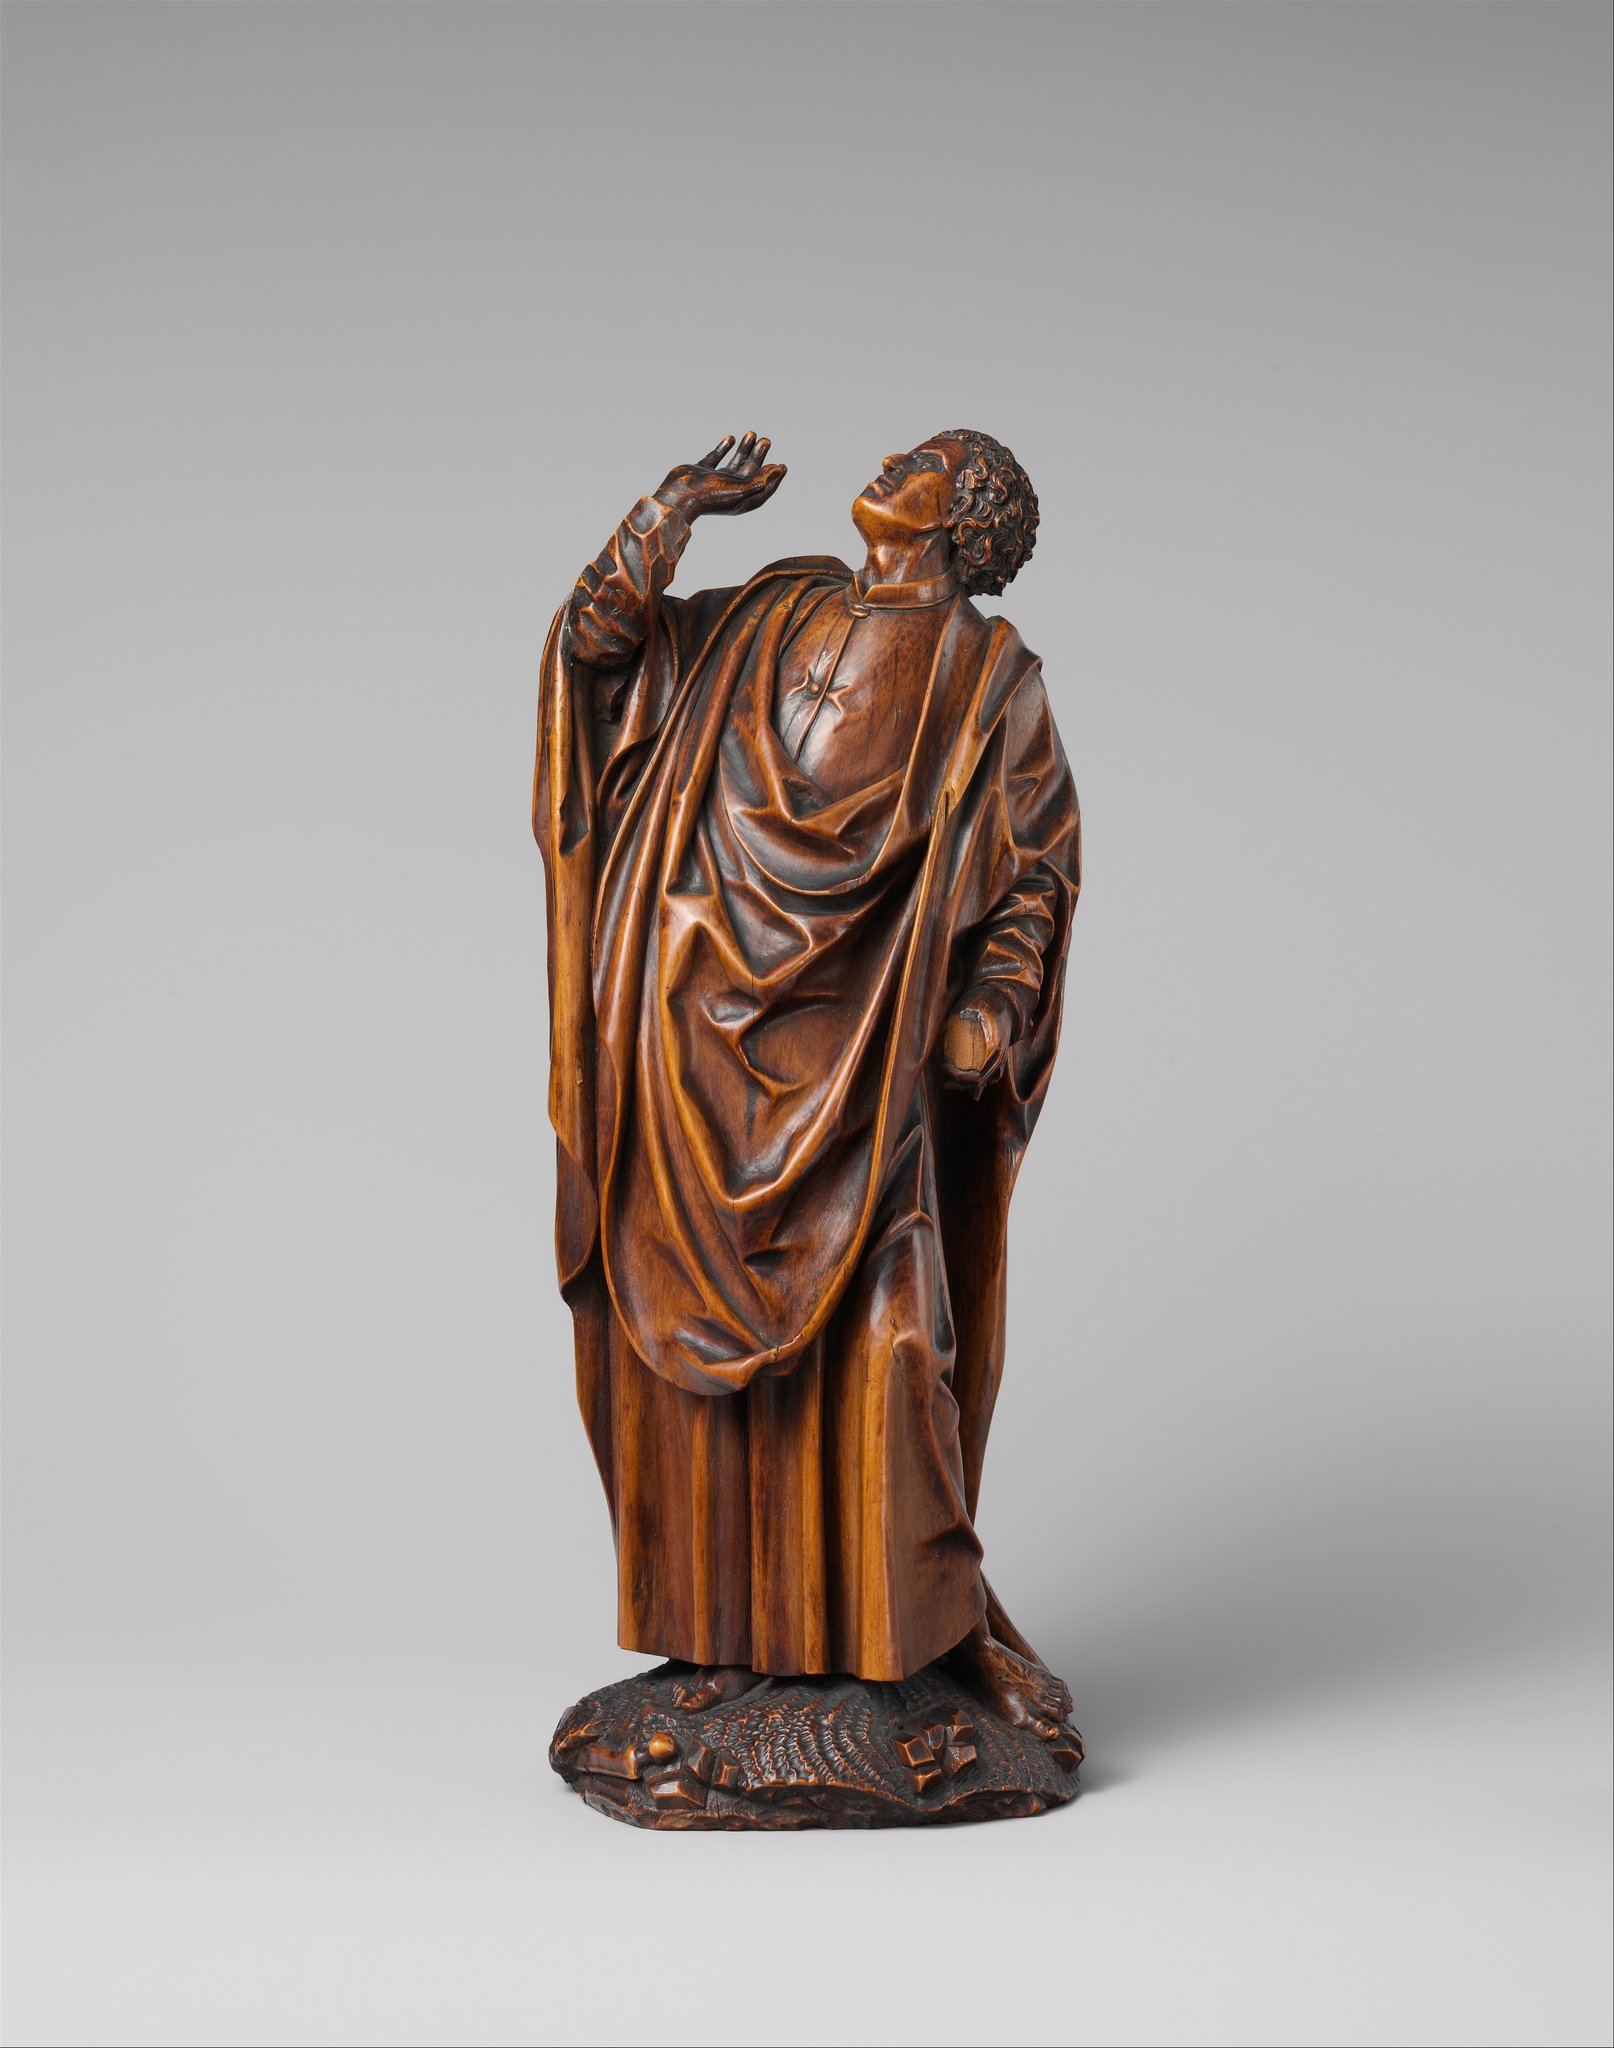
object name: statuette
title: Saint John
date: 1560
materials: wood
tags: men,saint john the baptist